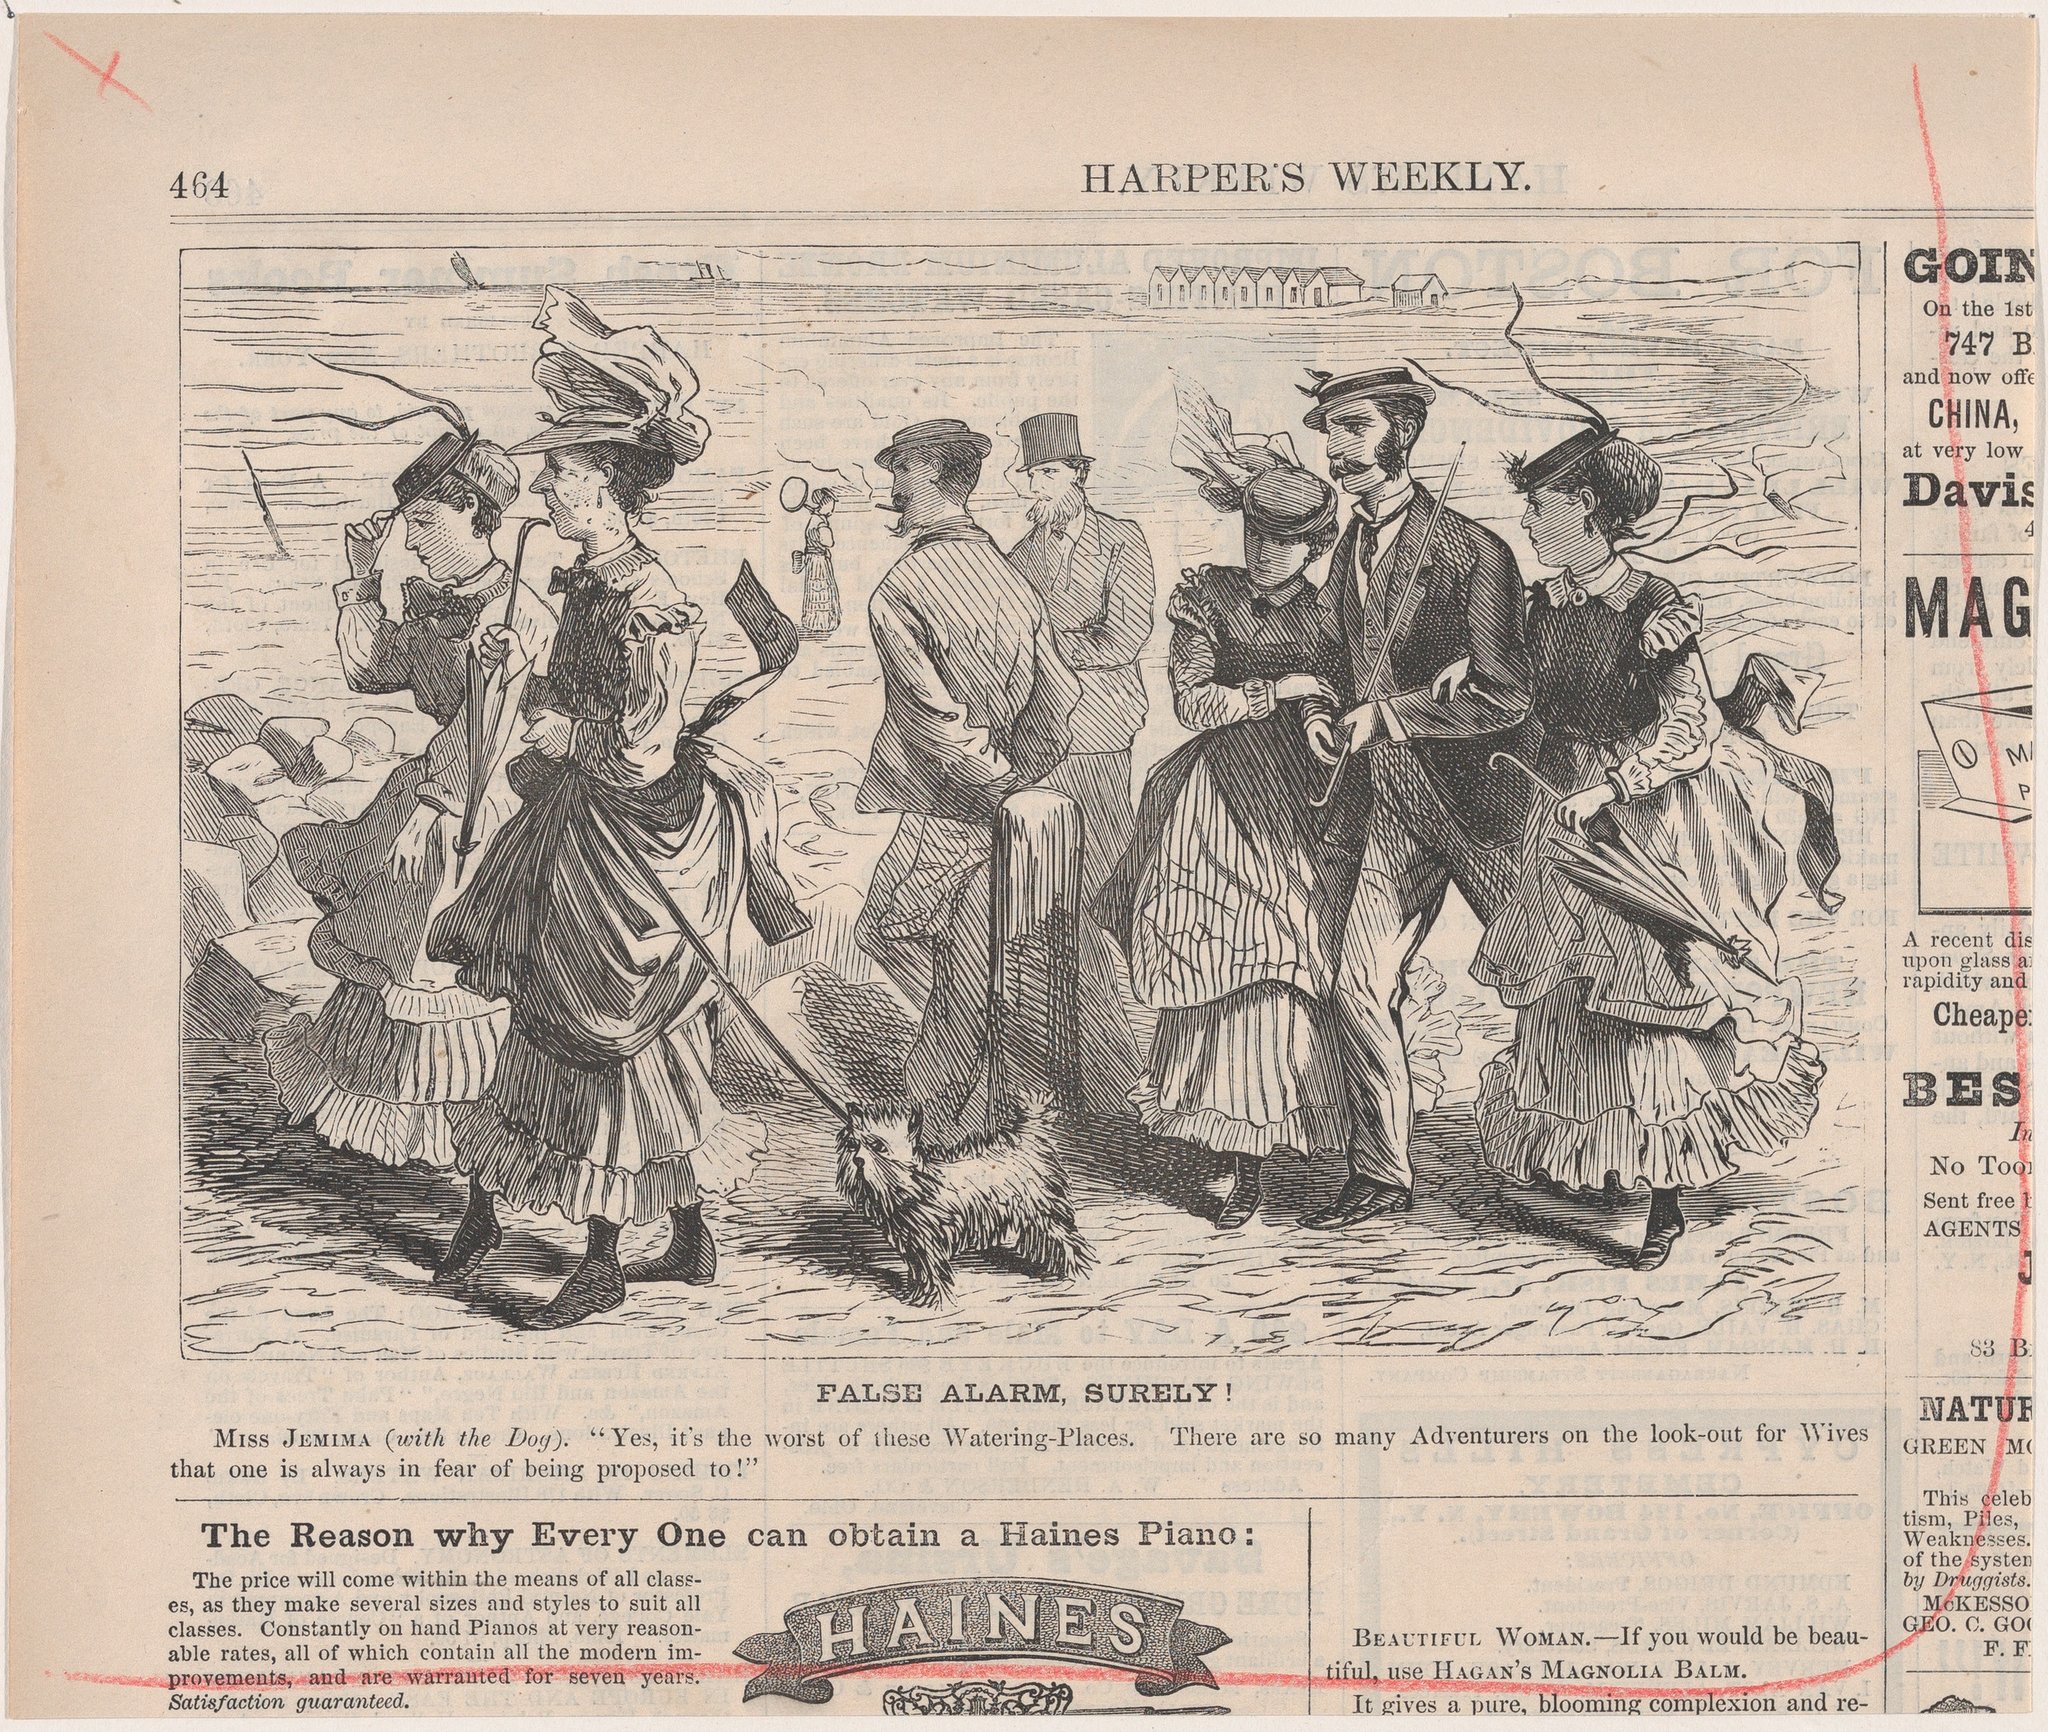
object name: print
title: False Alarm, Surely! (from "Harper's Weekly," Vol. XIII)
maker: winslow homer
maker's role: artist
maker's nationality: american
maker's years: 1836-1910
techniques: engraving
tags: men,women,smoking,dogs,umbrellas